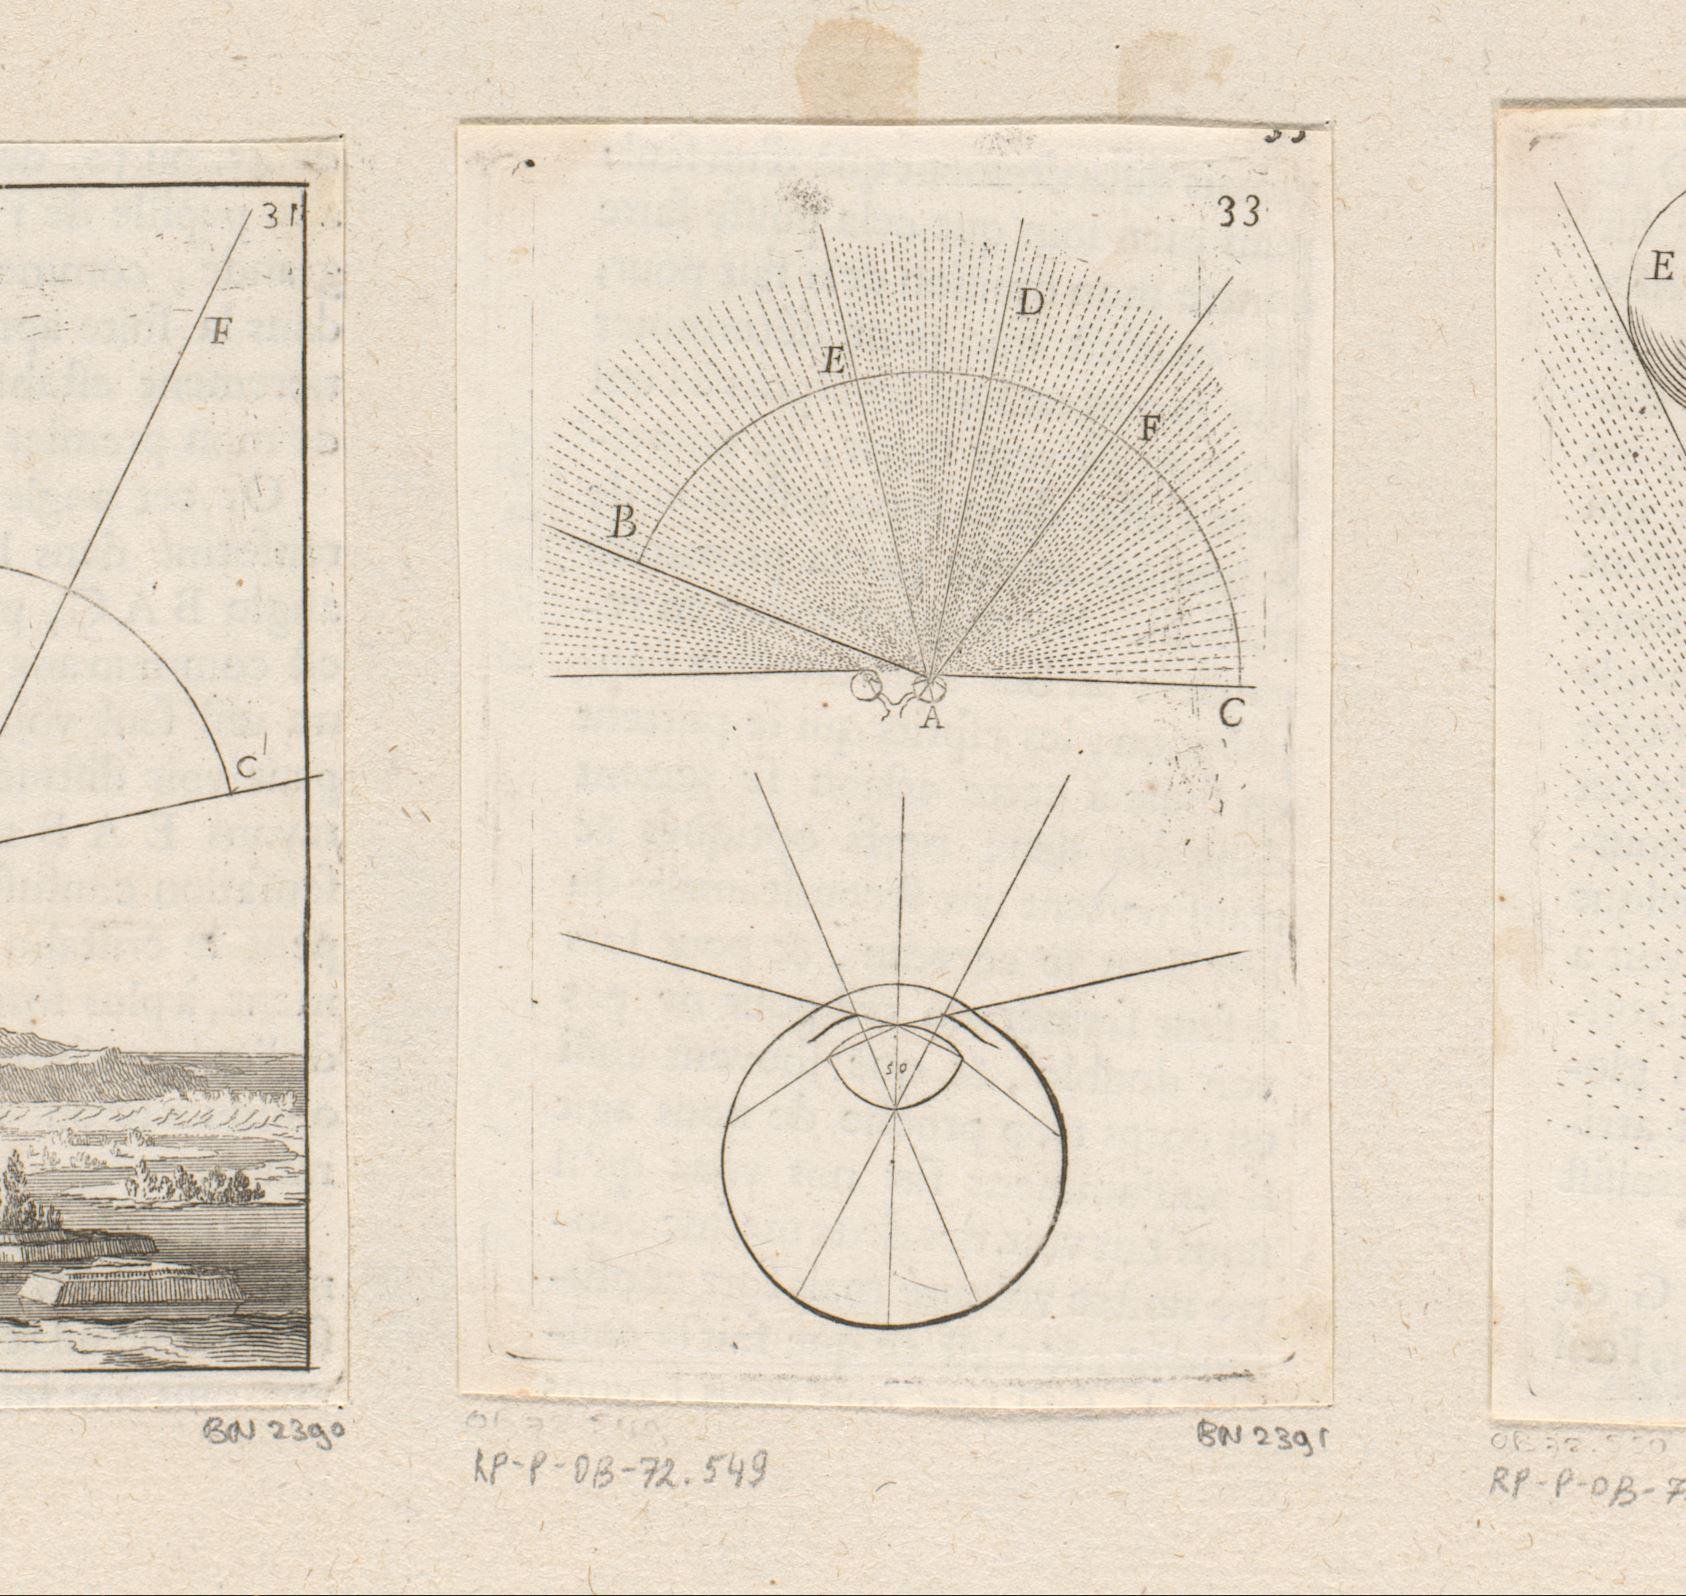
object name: book illustration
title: Gezichtsveld van een oog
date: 1679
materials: paper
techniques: etching, letterpress printing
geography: france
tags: optics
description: Prent uit: Leclerc, Sébastien. Discours touchant le point de veue, dans lequel il est prouvé que les choses qu'on voit (...). Parijs: Thomas Jolly, 1679.